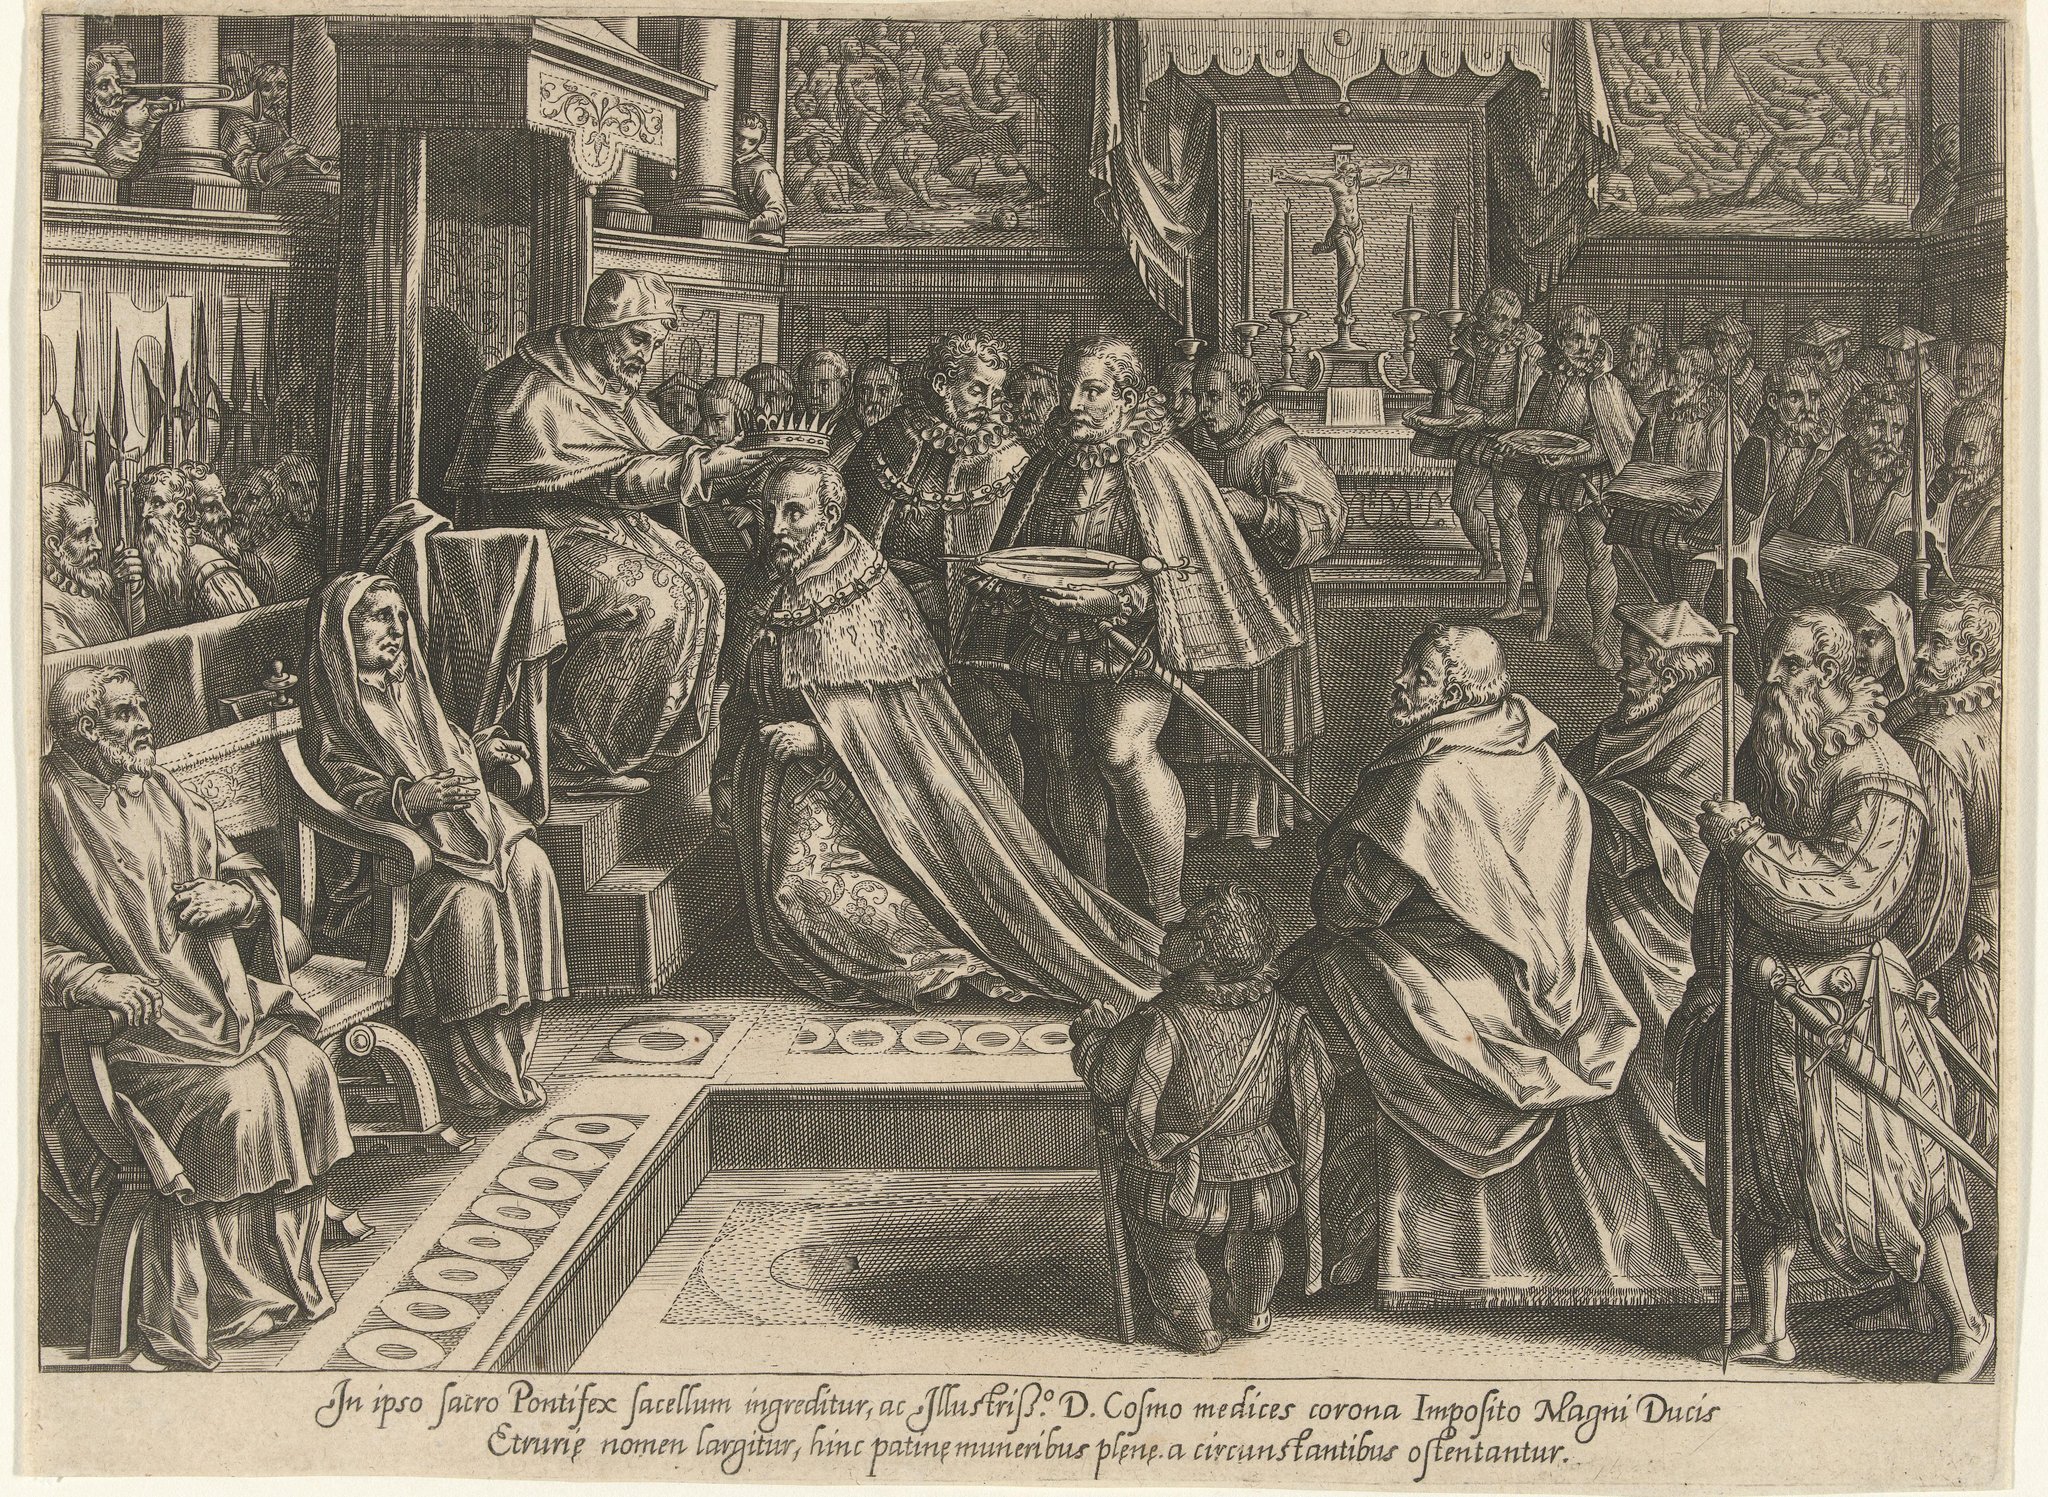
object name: history print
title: Kroning van Cosimo De' Medici in 1569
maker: philips galle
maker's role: print maker, publisher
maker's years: 1537-1612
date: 1583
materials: paper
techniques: engraving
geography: antwerp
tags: pius v, cosimo i de' medici, coronation of a ruler, rome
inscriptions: collector's mark: Lugt 2228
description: In de Sixtijnse kapel wordt Cosimo De' Medici in 1569 door Pius V gekroond tot groothertog van Toscane. Op de achtergrond het Laatste oordeel van Michelangelo. De prent heeft een Latijns onderschrift en maakt deel uit van een serie over de familiegeschiedenis van het geslacht De' Medici.